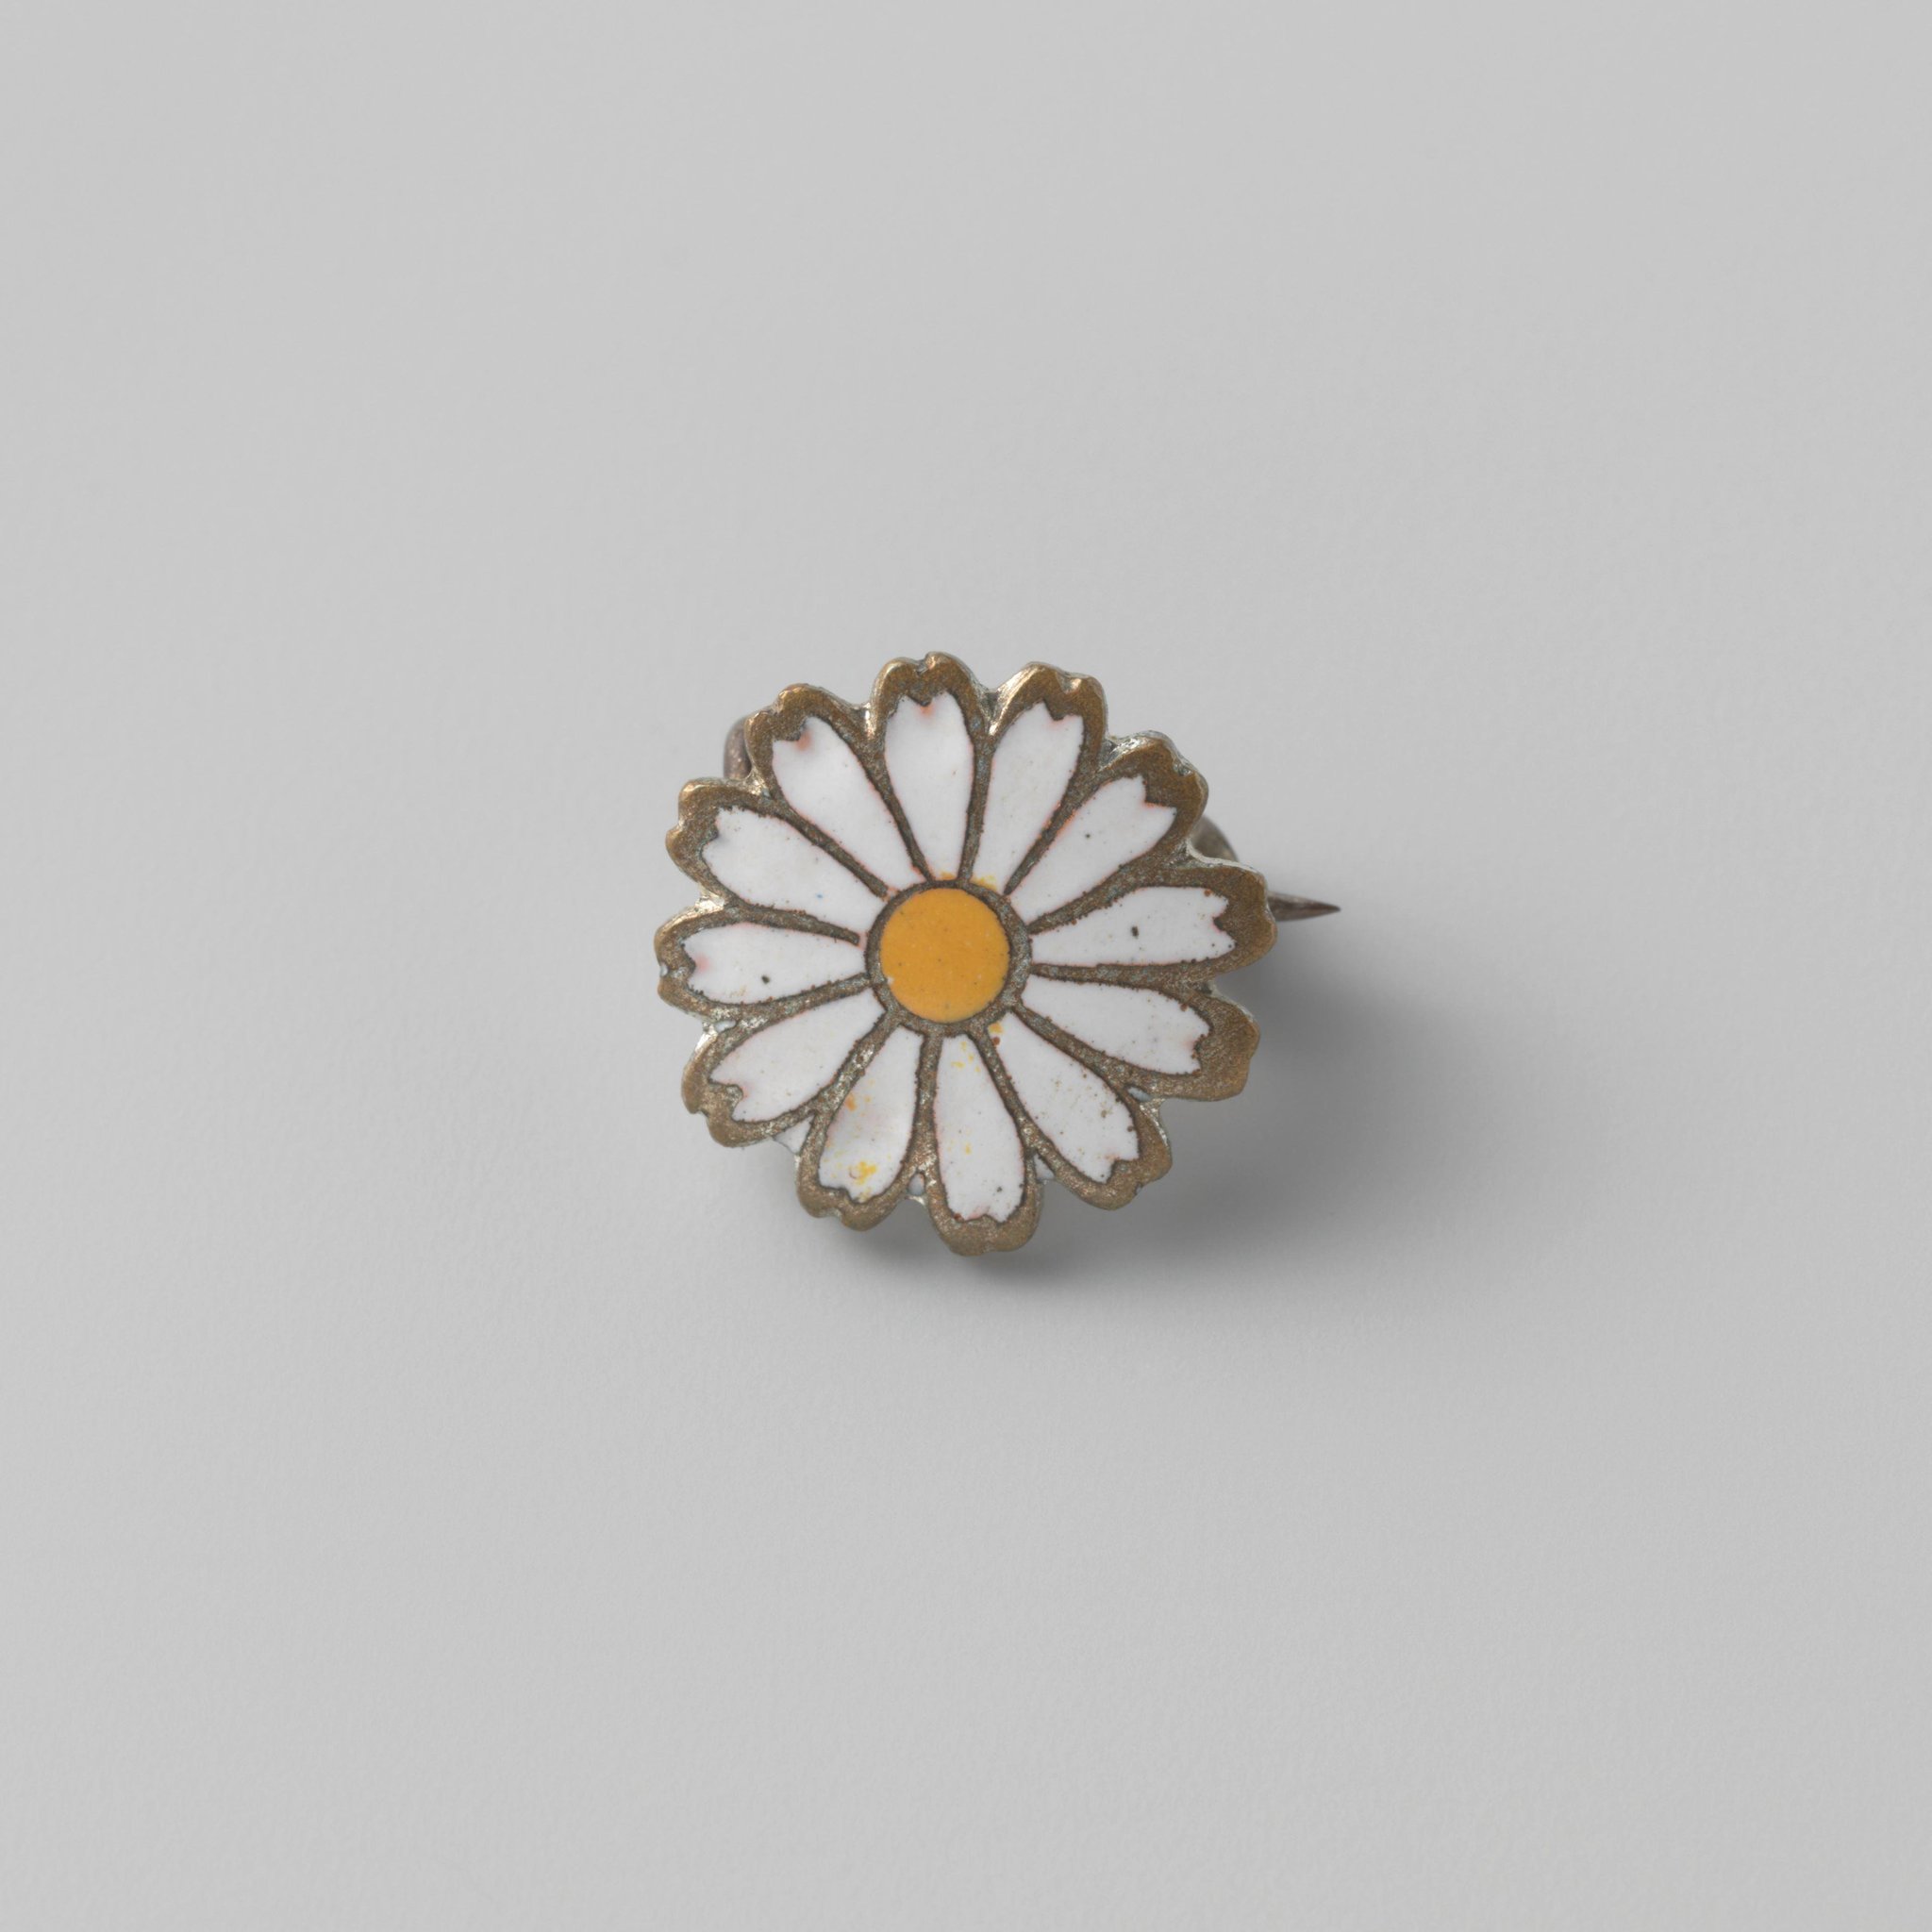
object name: brooch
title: Broche in de vorm van een margriet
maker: Anonymous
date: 1945-1955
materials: metal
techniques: enameling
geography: netherlands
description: Broche van geëmailleerd metaal in de vorm van een margriet voorzien van een haaksluiting. Broche van geëmailleerd metaal in de vorm van een margriet voorzien van een haaksluiting. Deze kleine broches werden verkocht ter ondersteuning van het in de Tweede Wereldoorlog opgerichte Prinses Magrietfonds. Prinses Margriet, de derde dochter van prinses Juliana en prins Bernhard, werd in 1943 in Ottawa (Canada) geboren en werd de beschermvrouwe van de Nederlandse Koopvaardij. Margrietspeldjes zijn er in verschillende varianten en werden gedragen door personeel van de rederijen en hun echtgenoten.